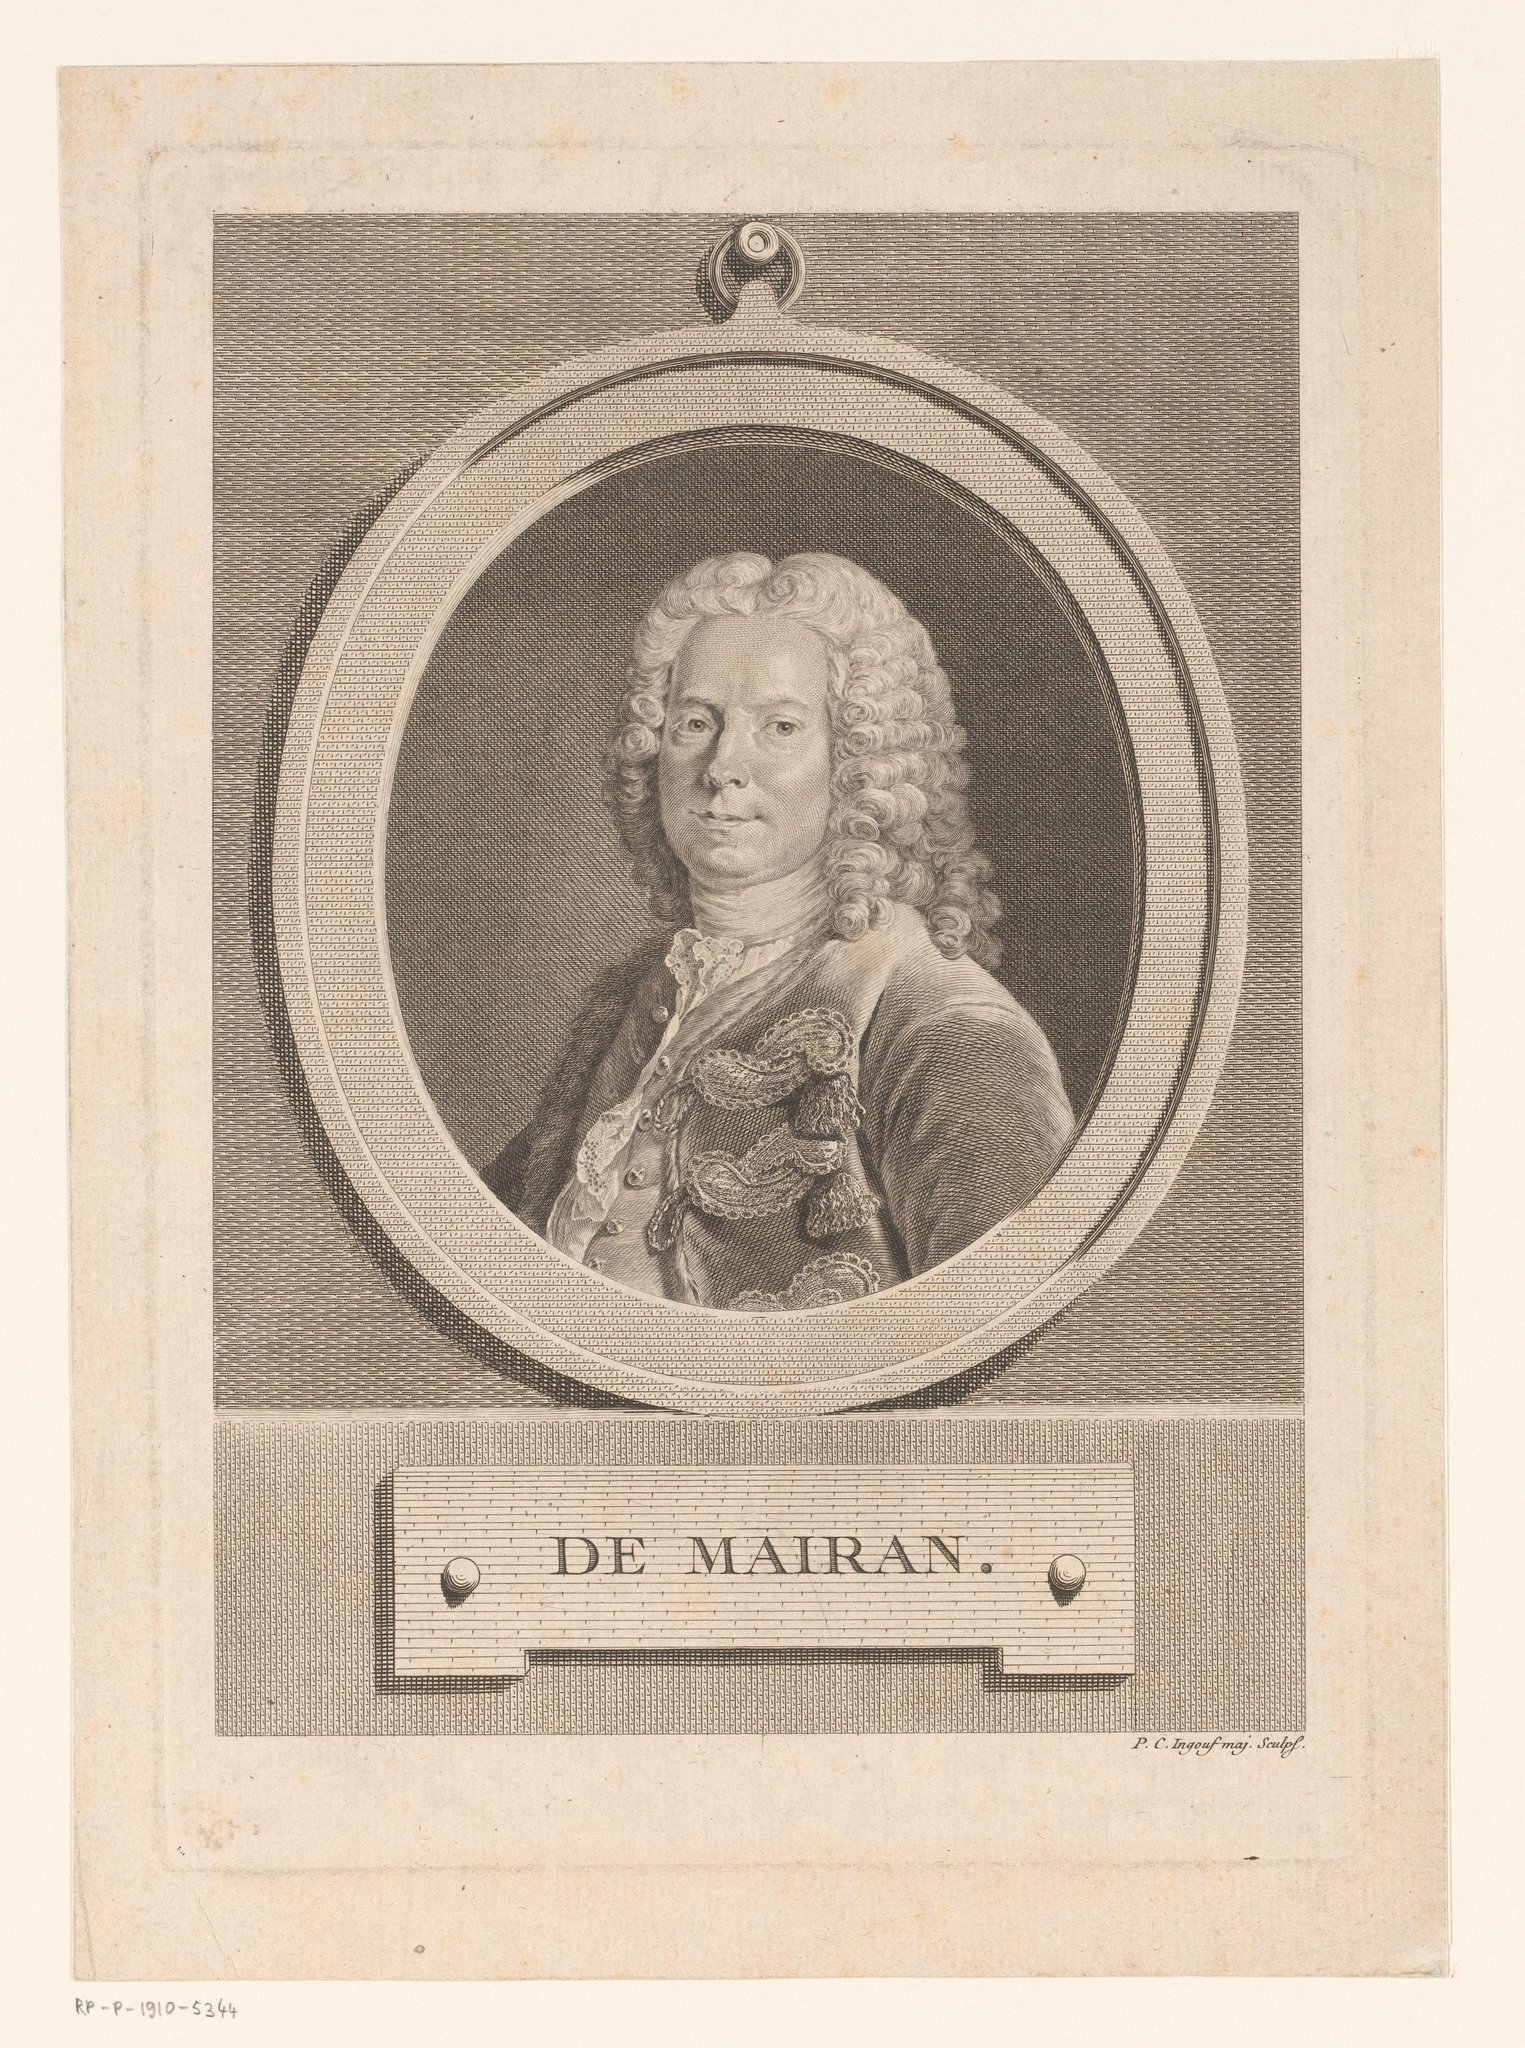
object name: print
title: Portret van Jean Jacques de Mairan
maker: pierre charles ingouf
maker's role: print maker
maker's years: 1746-1800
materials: paper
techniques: engraving, etching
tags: france, paris, historical persons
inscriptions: collector's mark: Lugt 2228